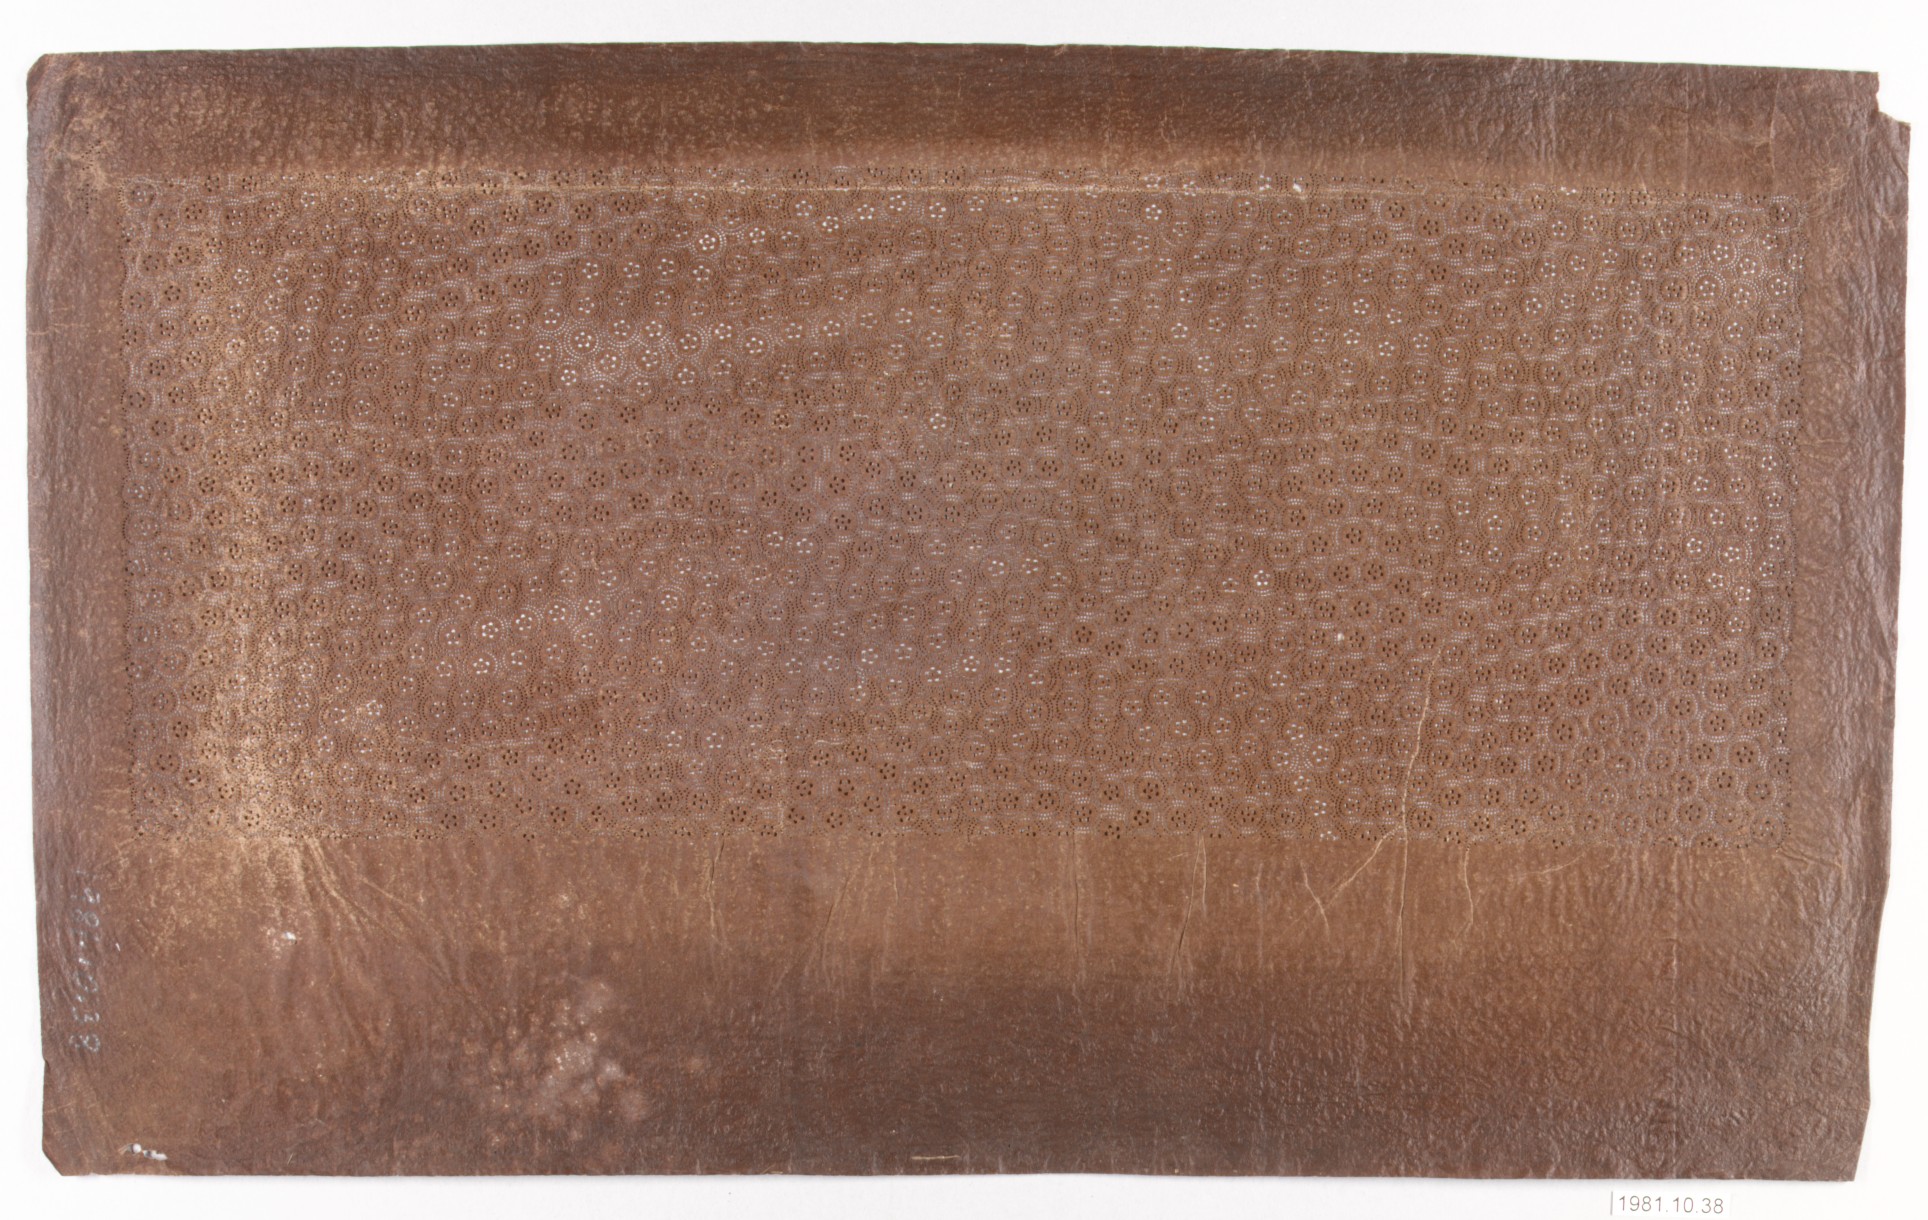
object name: stencil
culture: japanese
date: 1801-1900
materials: paper